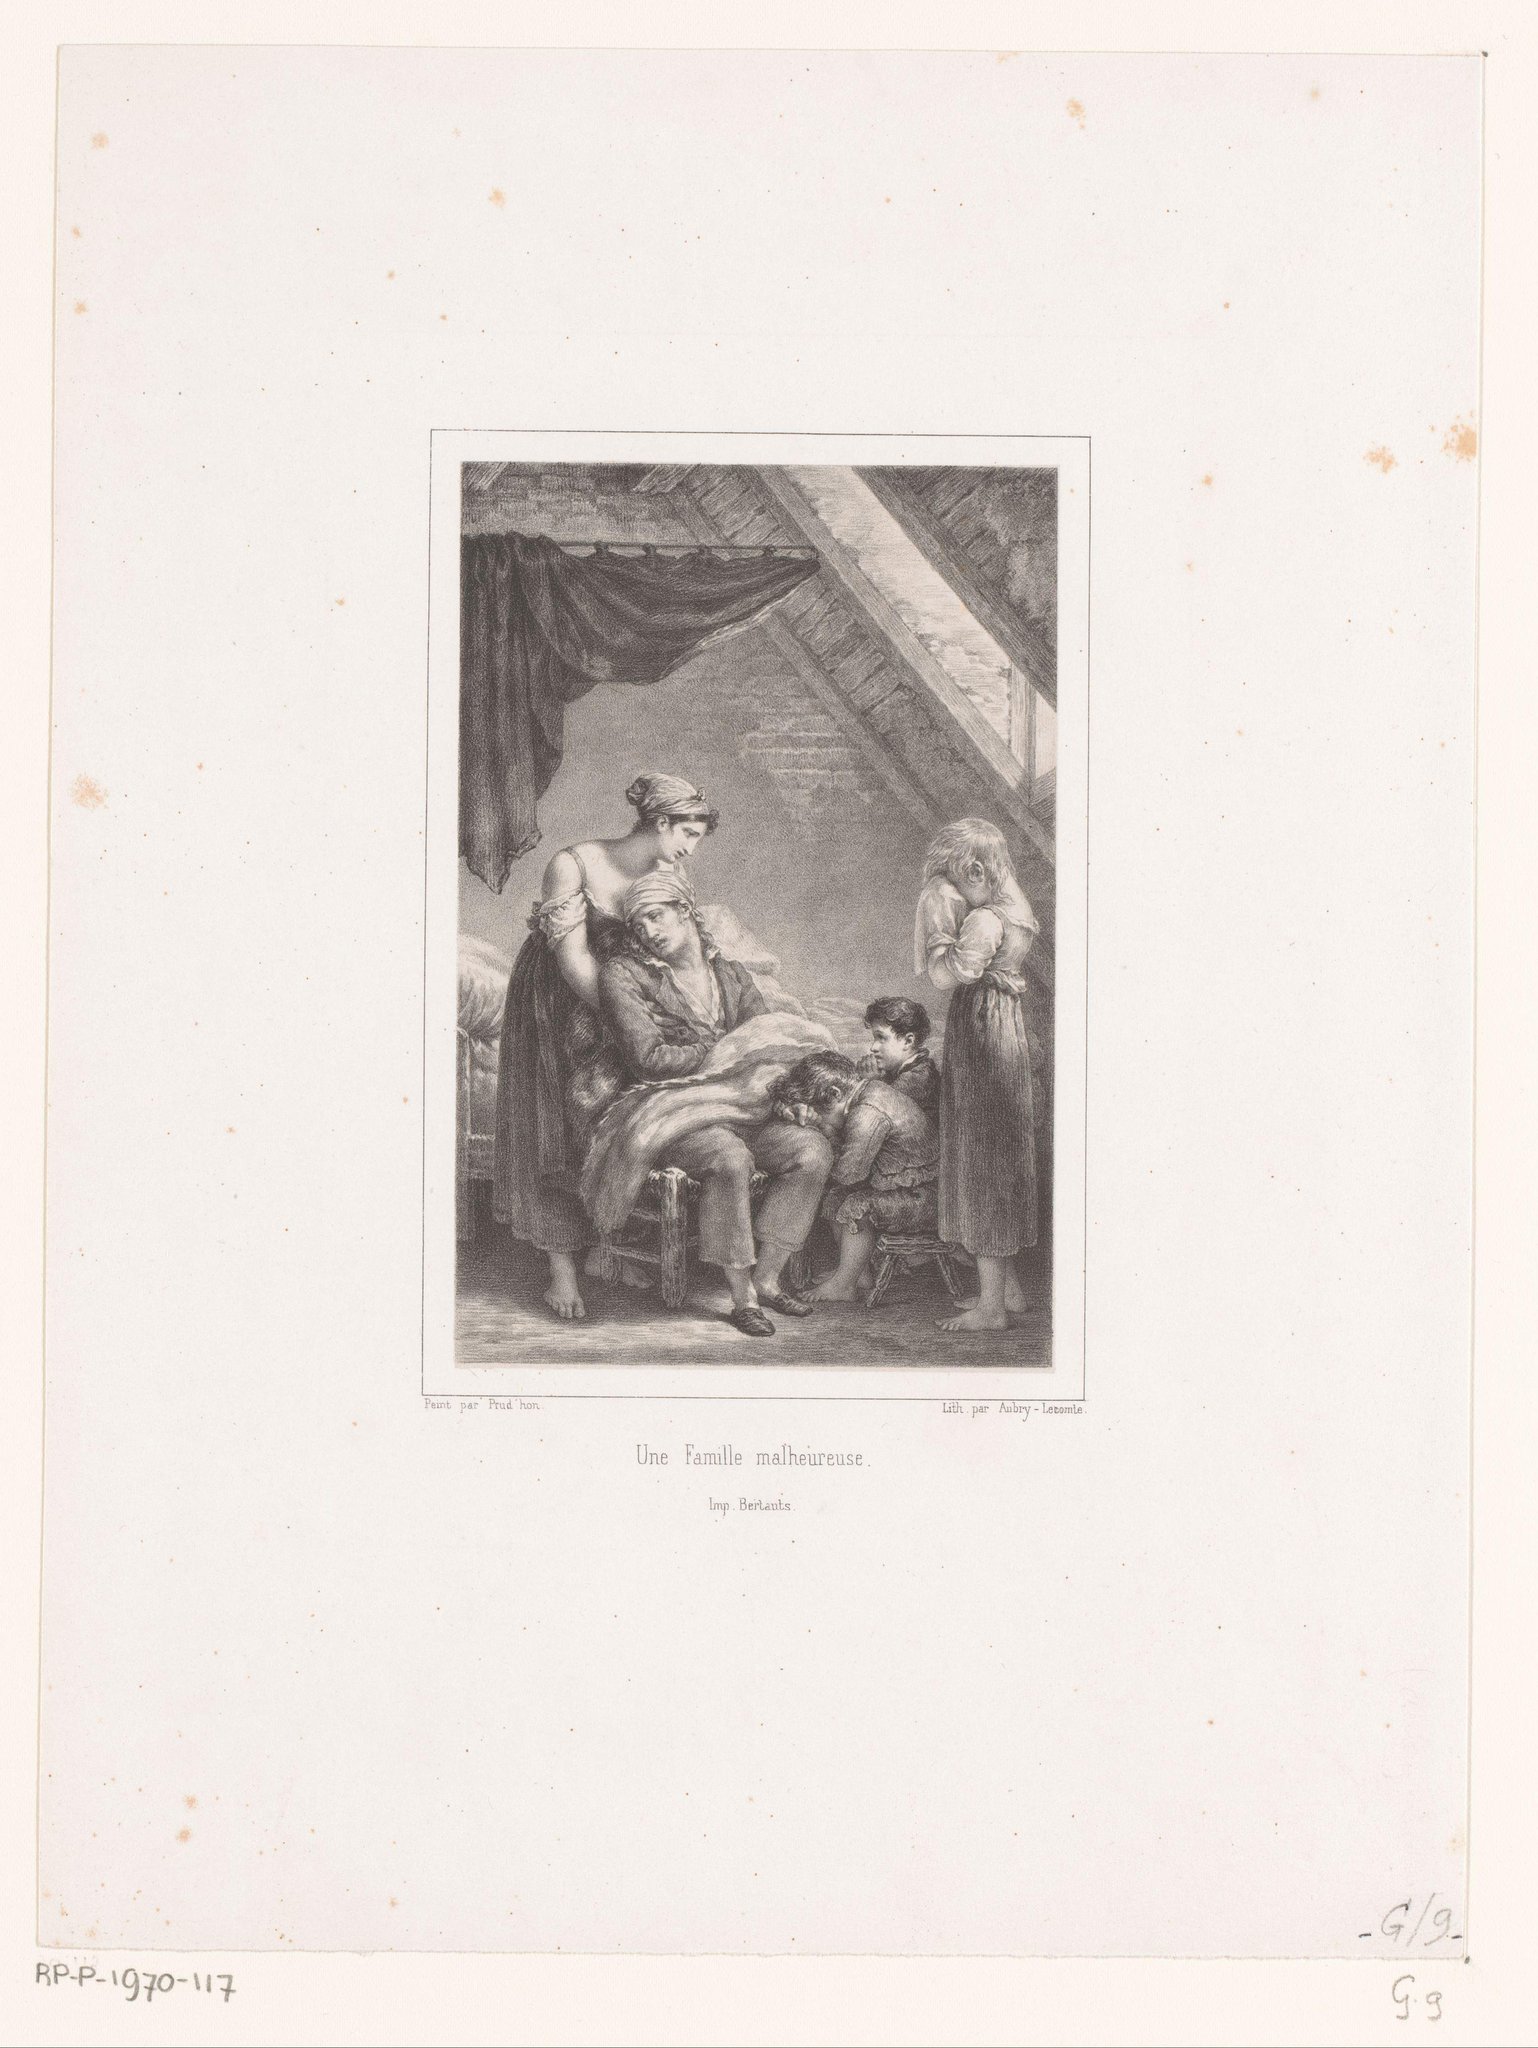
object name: print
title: Gezin treurend rond zieke man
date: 1822-1858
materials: paper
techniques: lithograph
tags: family, relationship, descent, patient, sick person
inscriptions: collector's mark: Lugt 2228, collector's mark: Lugt 2760